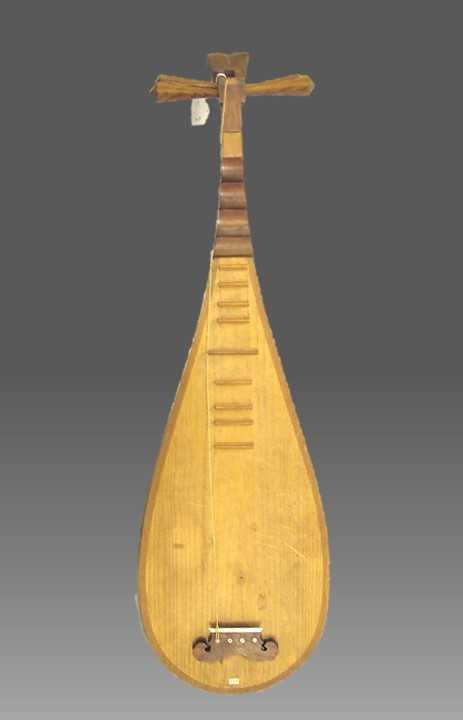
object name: pipa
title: Pipa (琵琶 )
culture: chinese or japanese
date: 1801-1900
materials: wood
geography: china